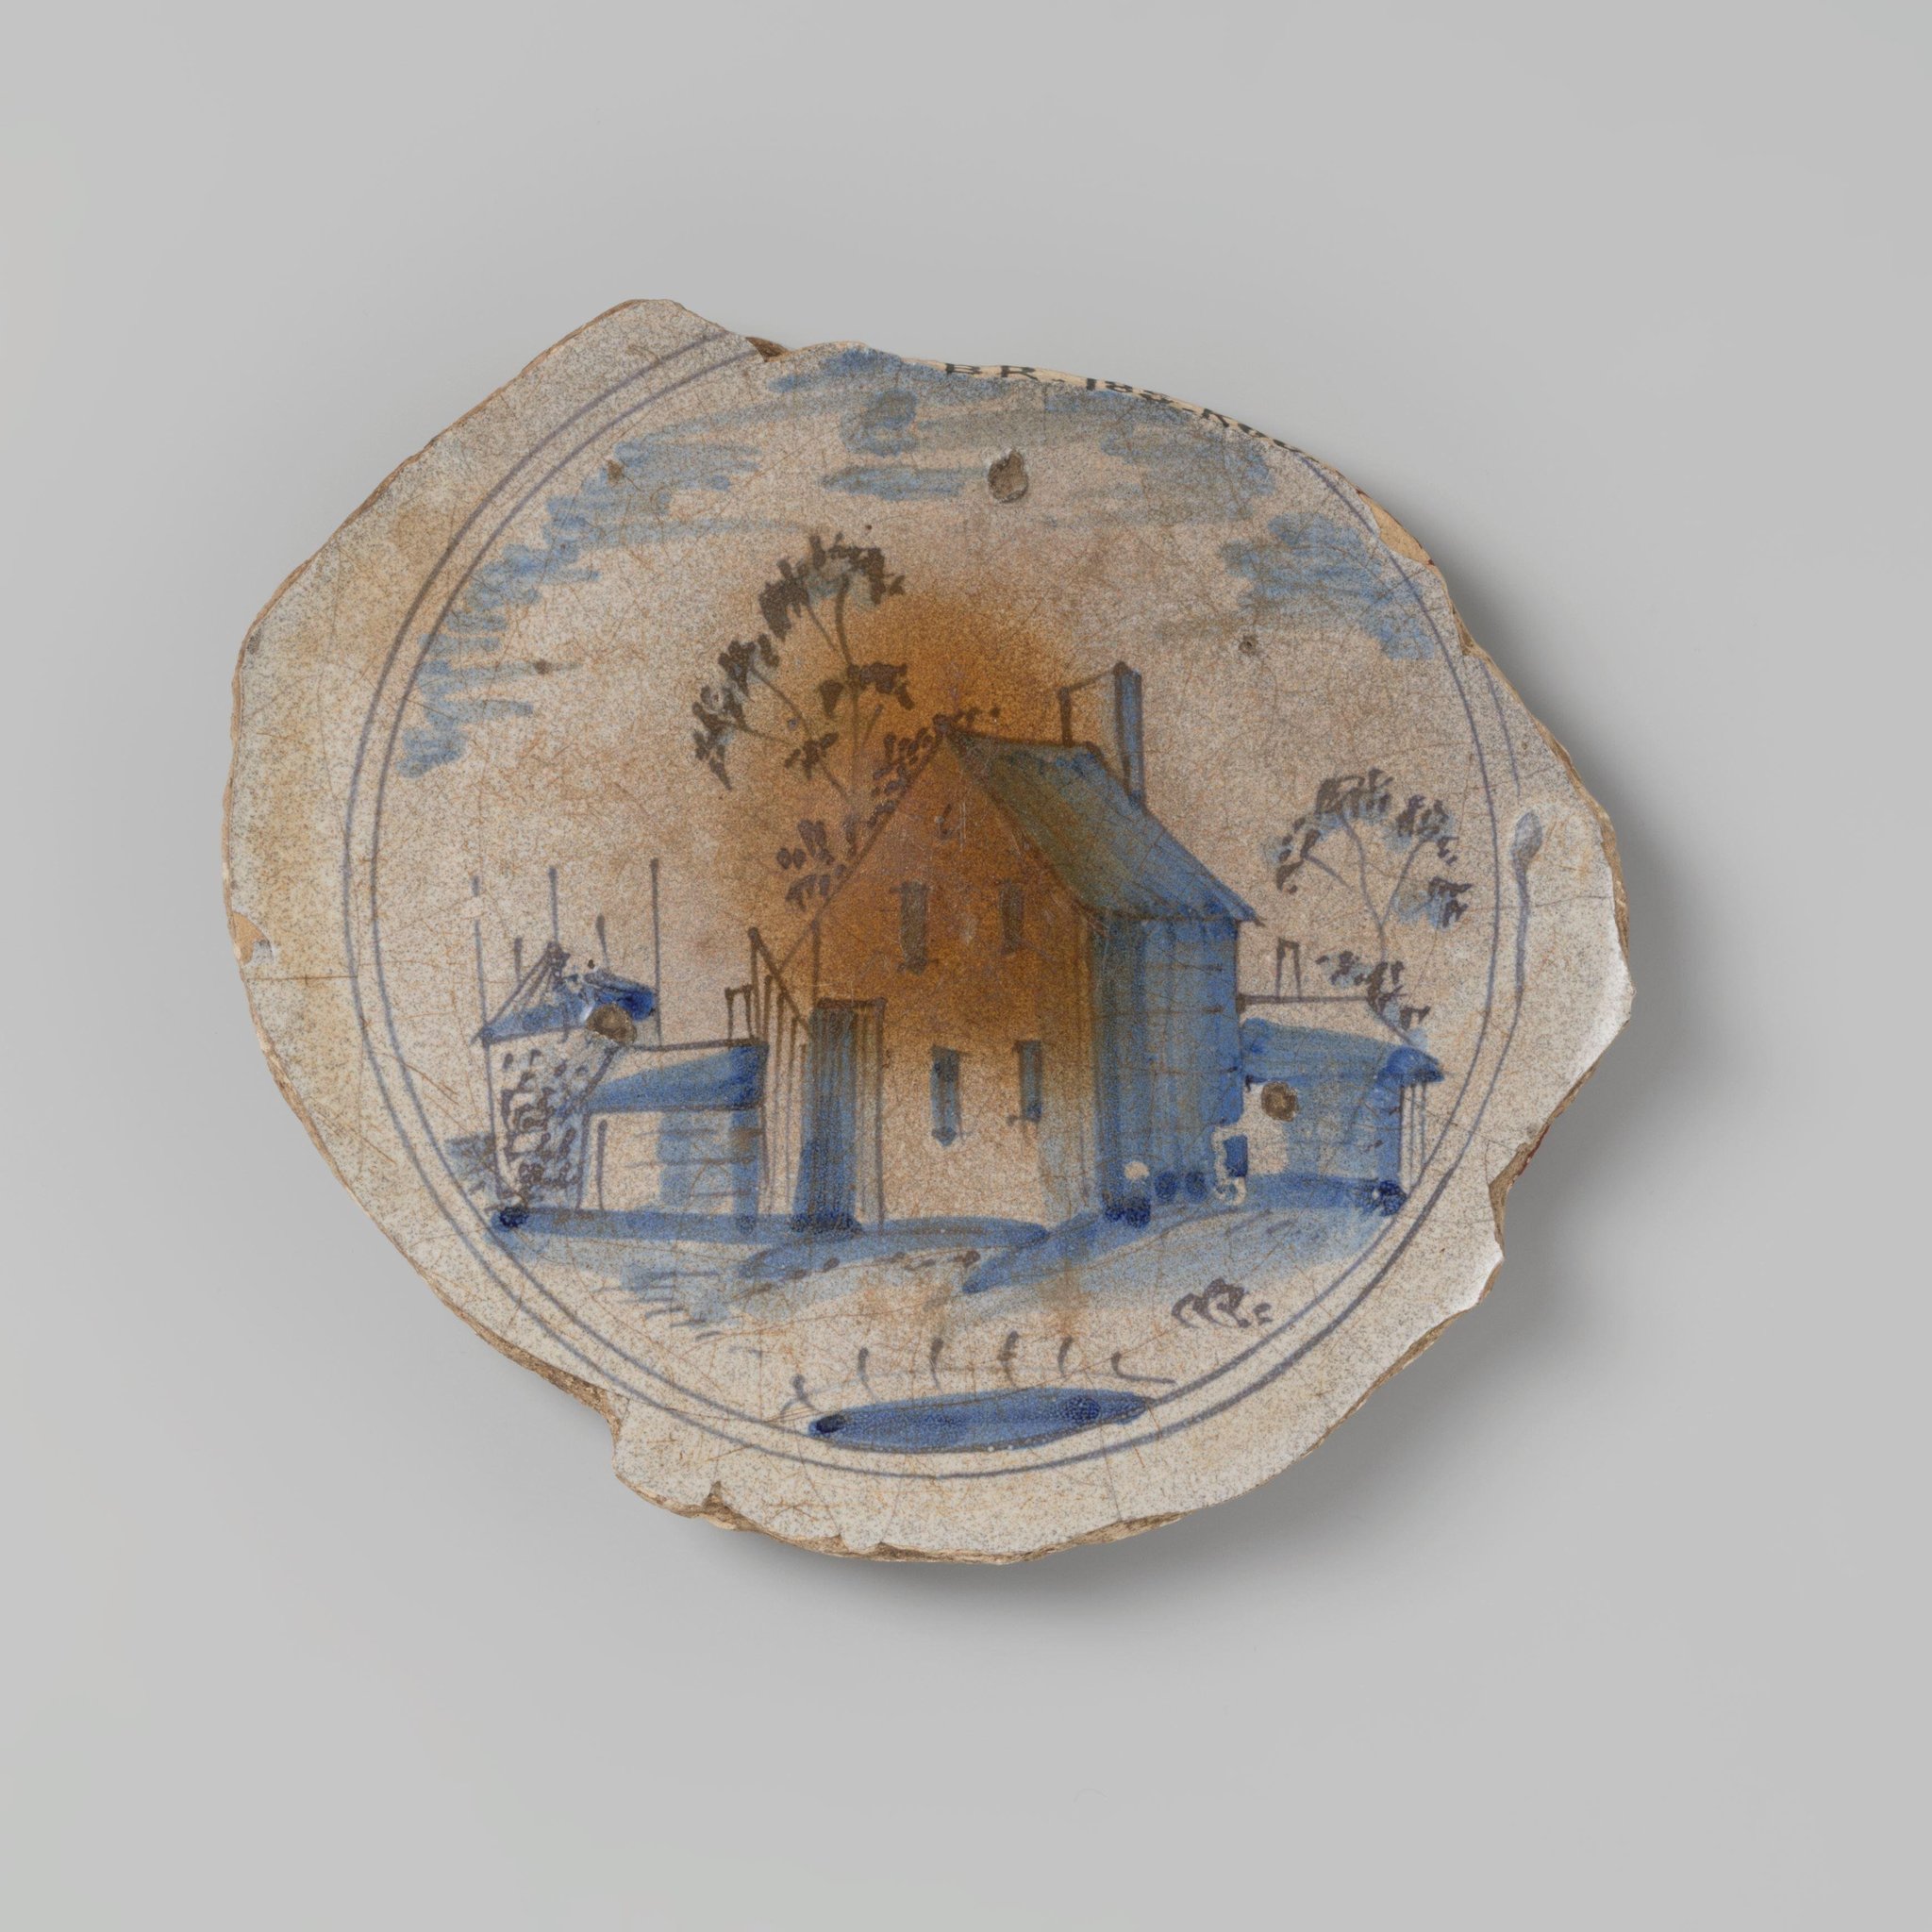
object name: sherd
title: Schotelscherf van aardewerk, voorzien van loodglazuur aan de onderzijde en wit tinglazuur aan de bovenzijde, en in blauw een voorstelling van een boerderij in een landschap, beschadigd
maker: Anonymous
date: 1500-1799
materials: earthenware, glaze